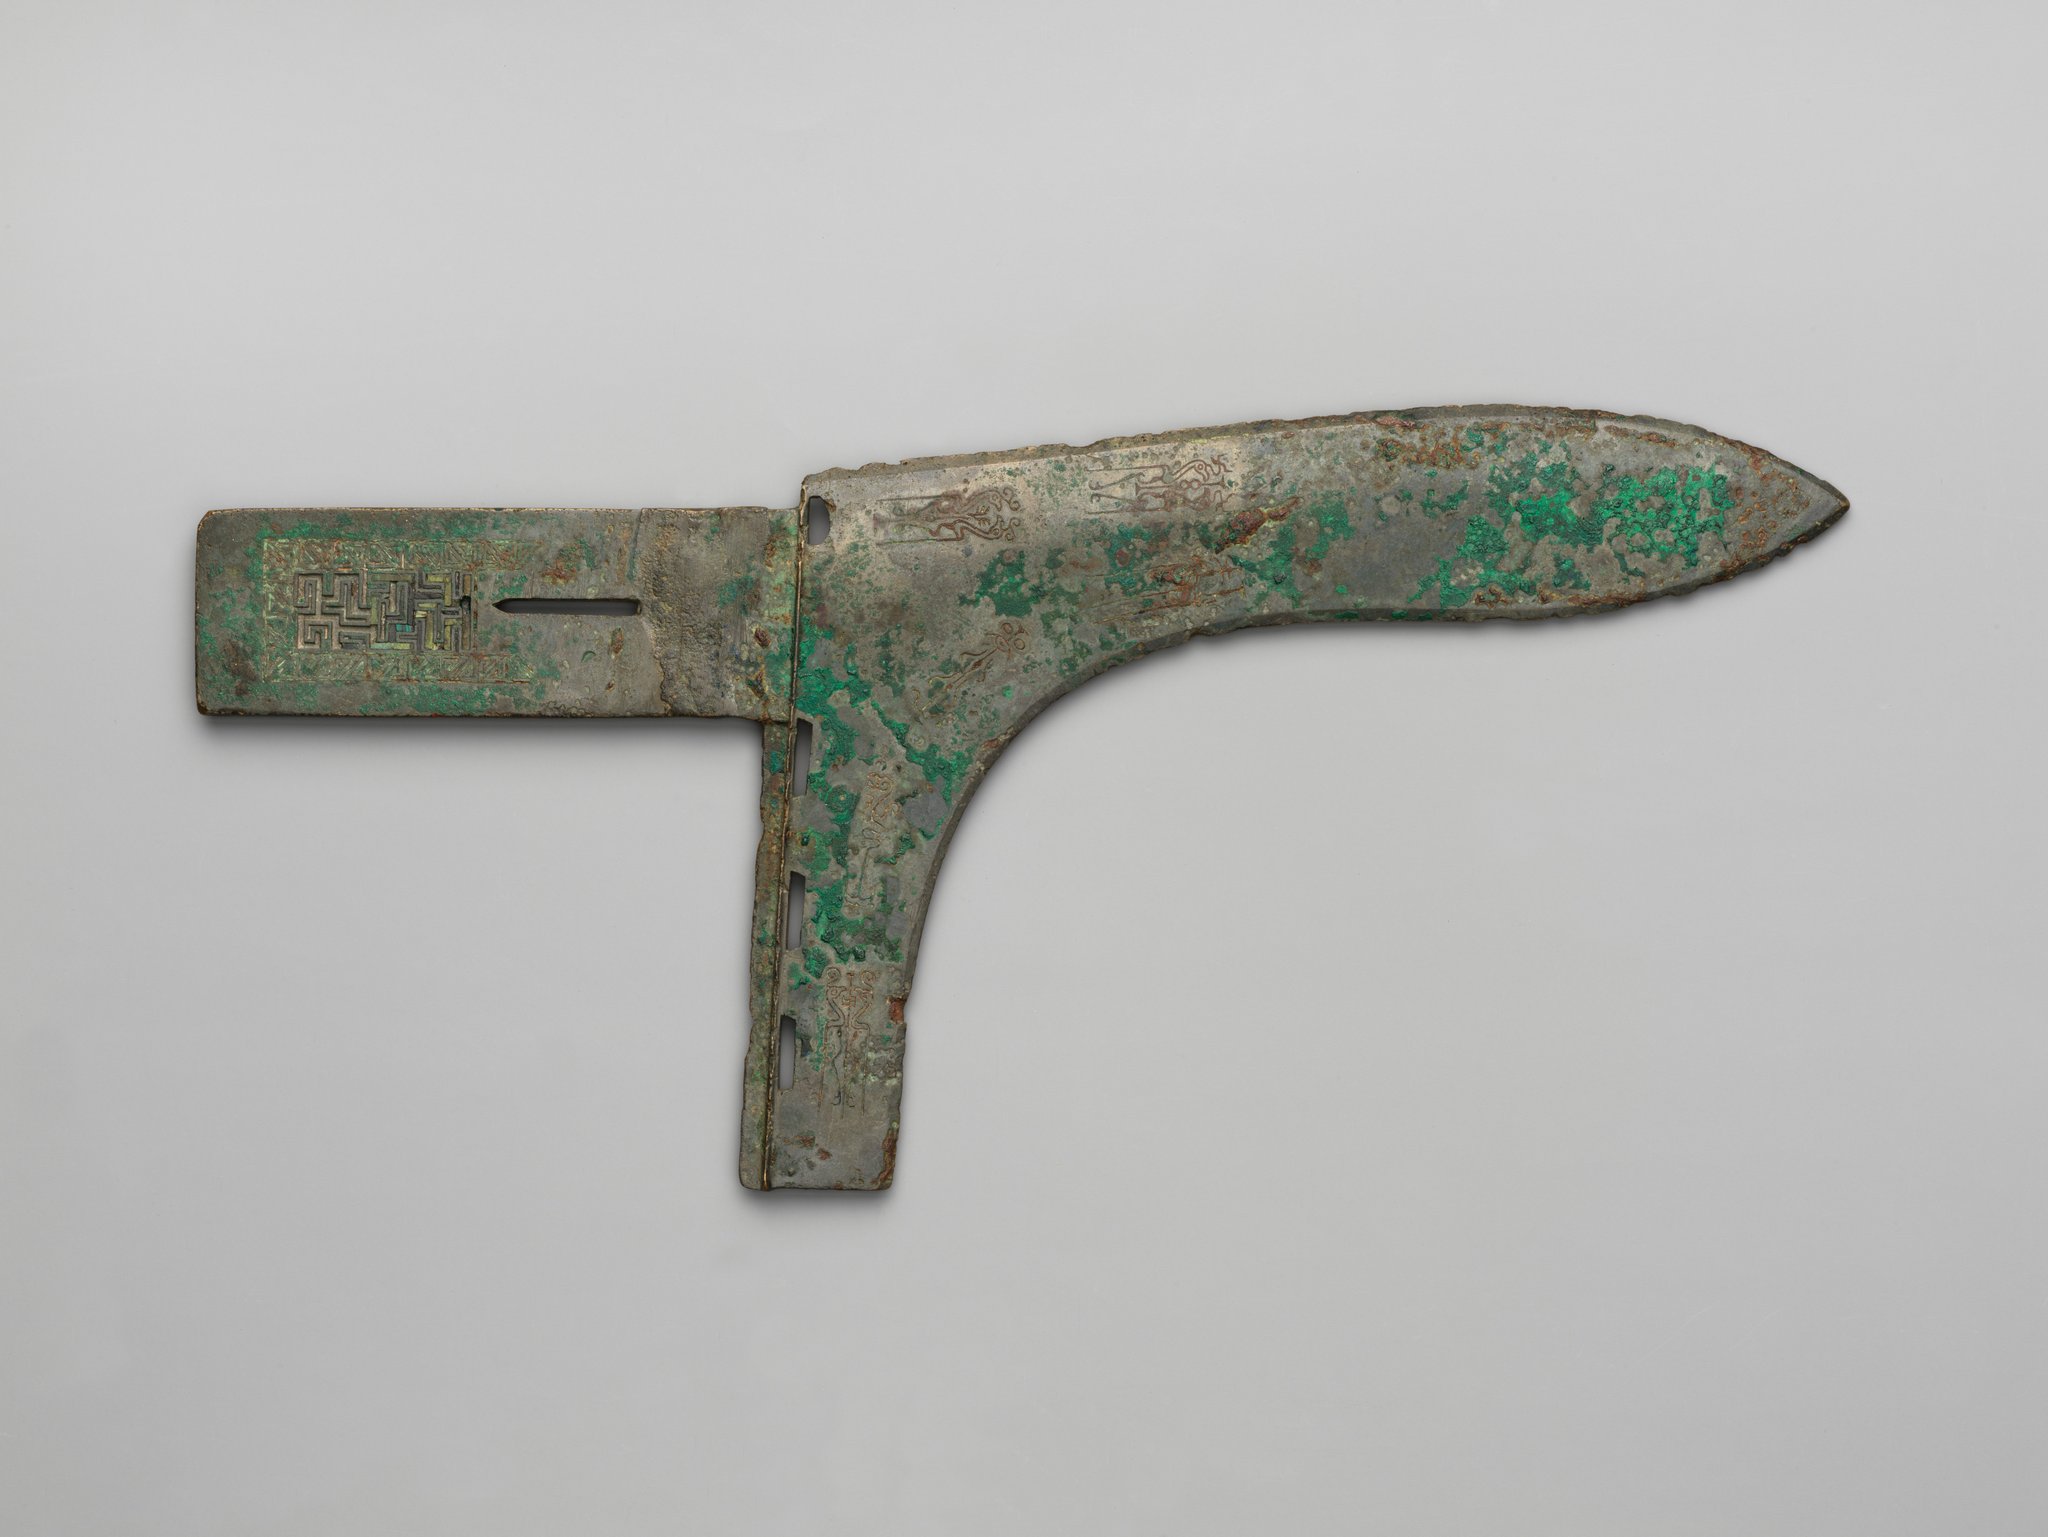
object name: halberd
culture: chinese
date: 500-301 BCE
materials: bronze, copper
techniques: inlay